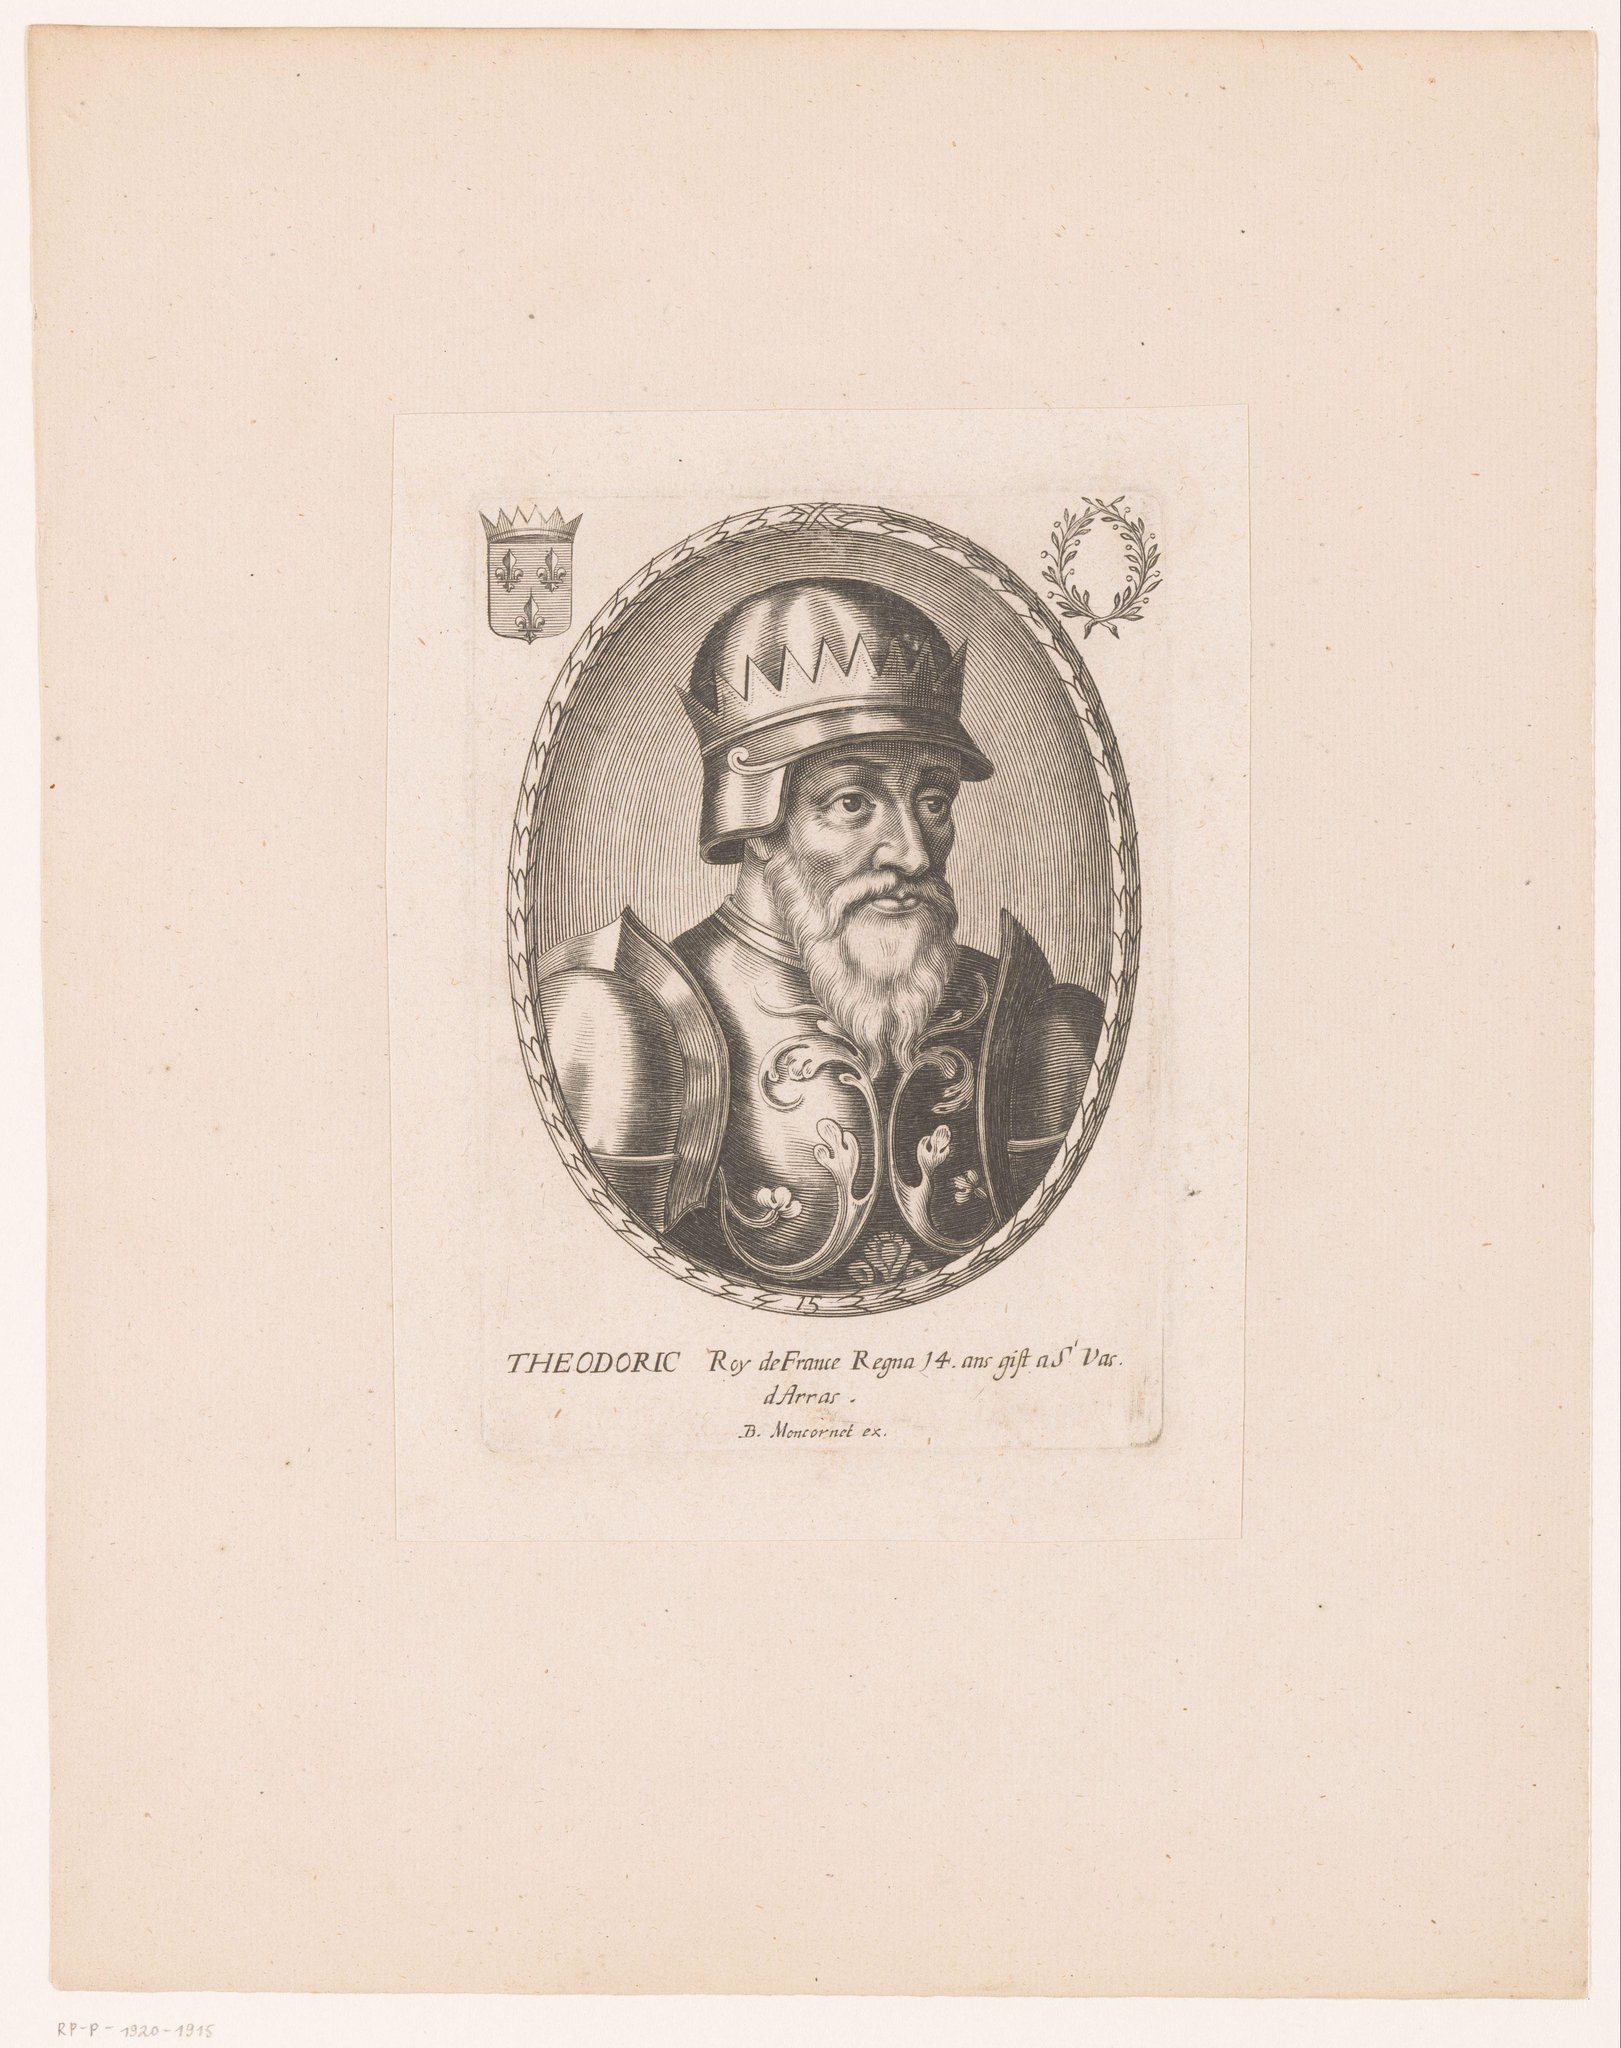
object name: print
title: Portret van Theodorik I van Frankrijk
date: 1610-1668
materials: paper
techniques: engraving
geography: paris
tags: historical persons, king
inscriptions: collector's mark: Lugt 2228